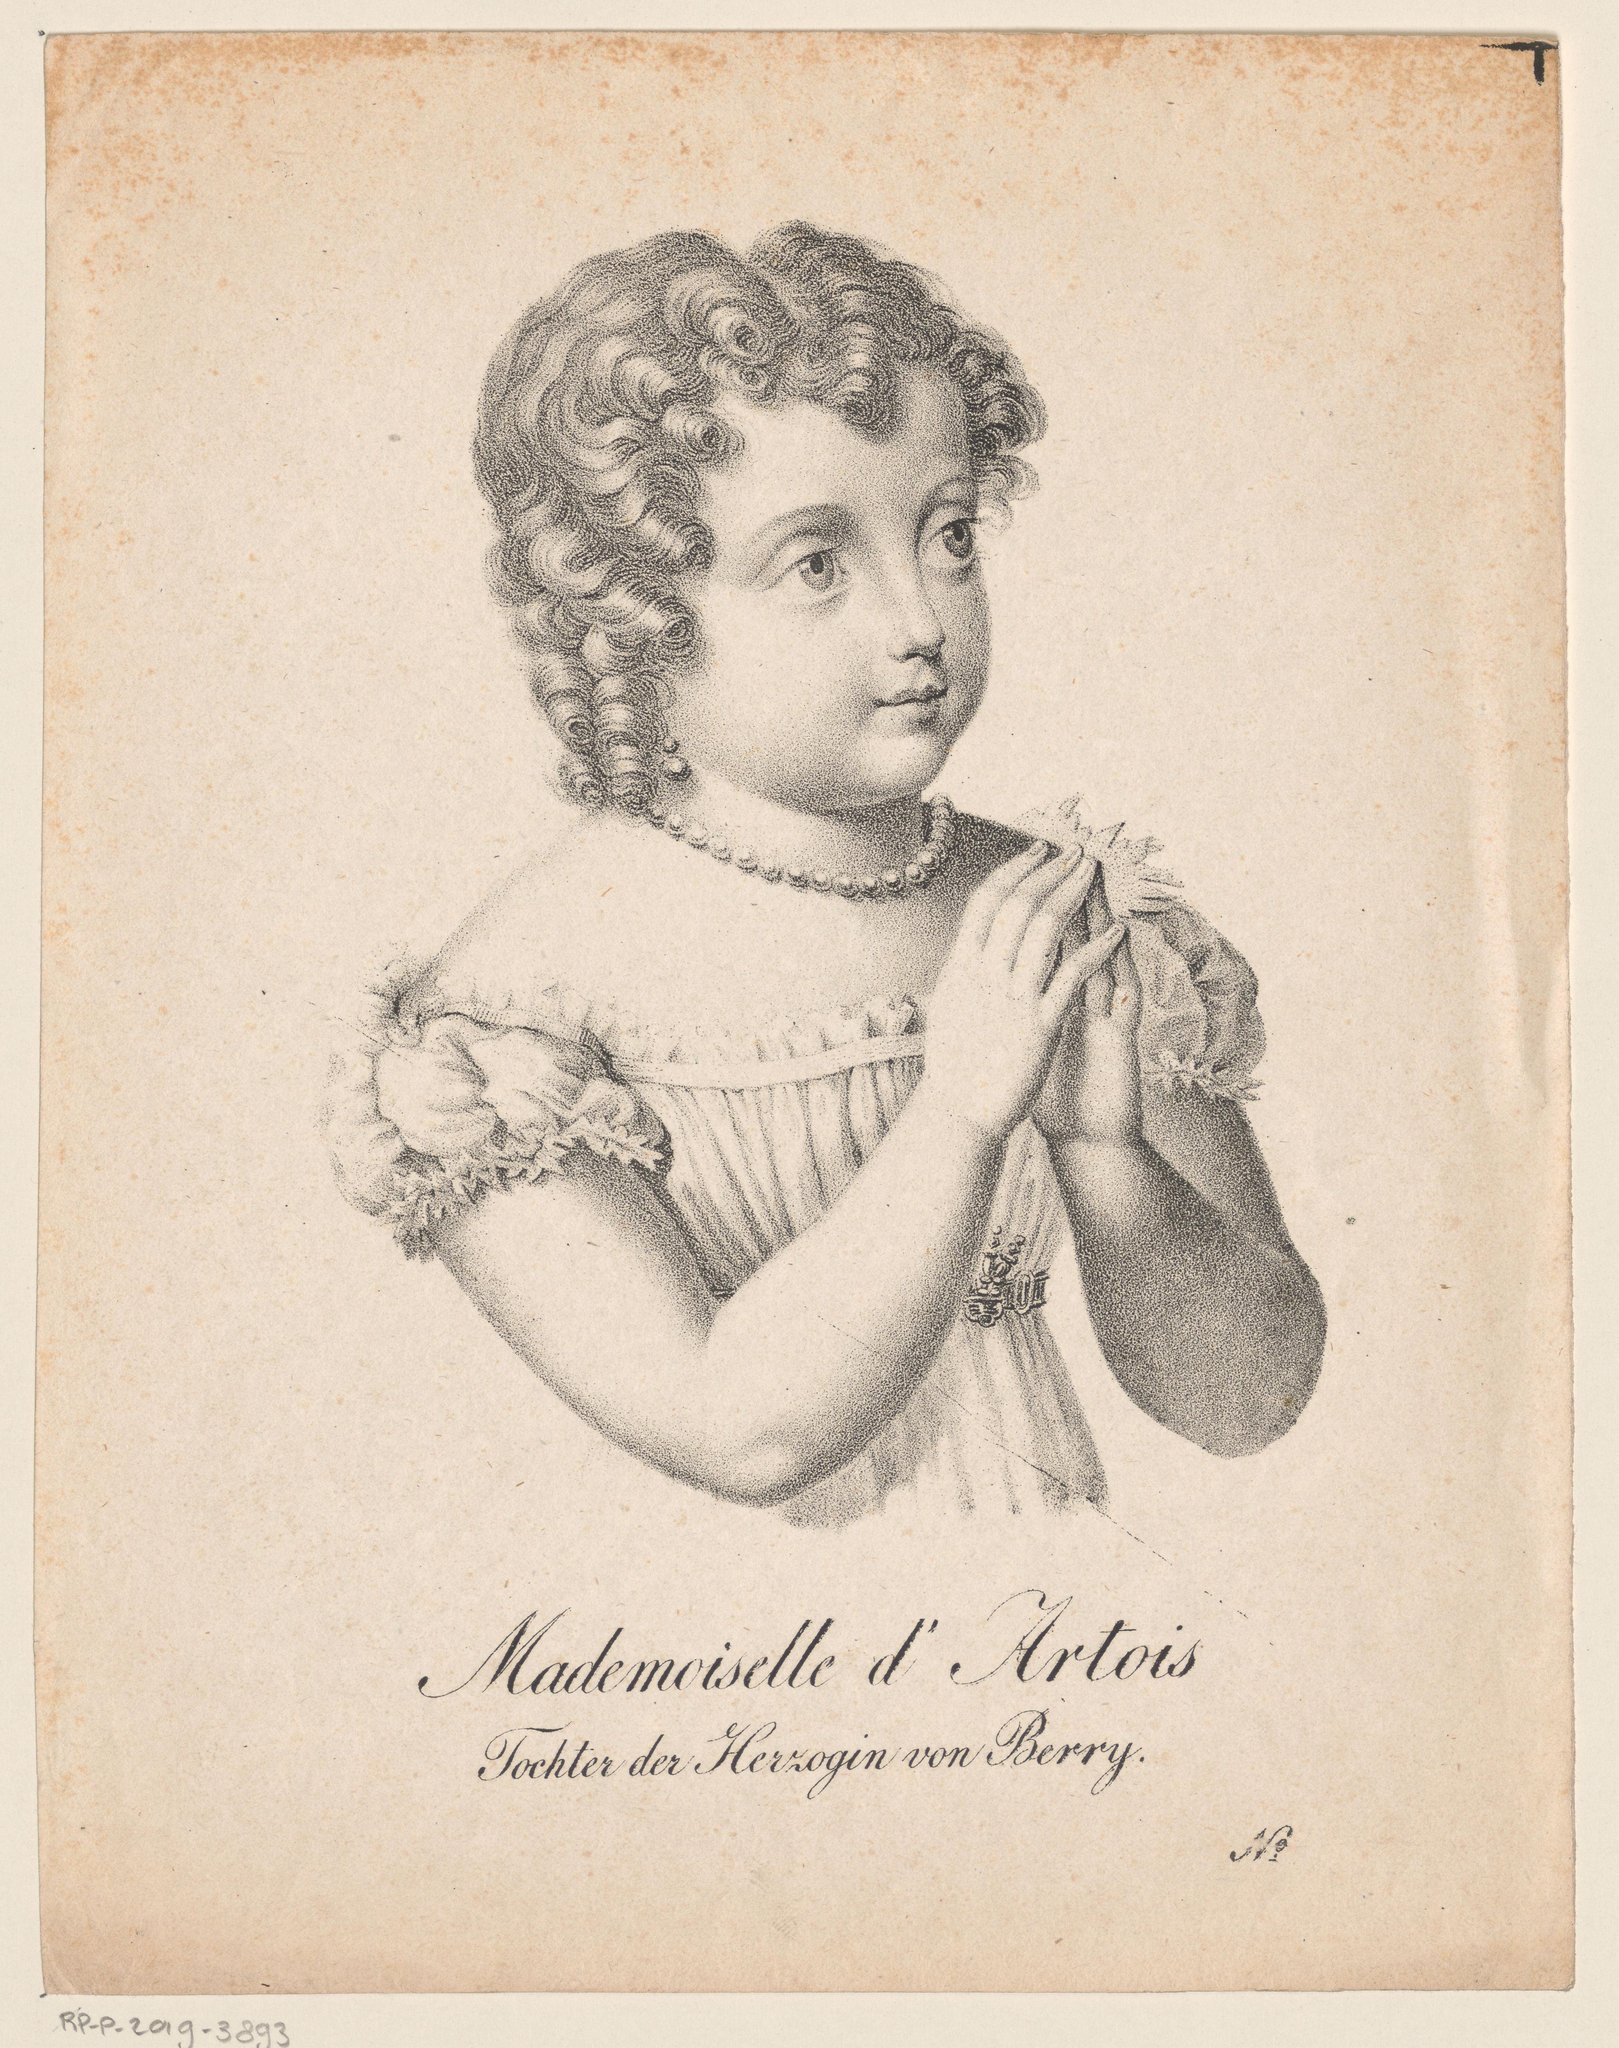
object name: print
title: Portret van Louise Marie Thérèse d'Artois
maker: Anonymous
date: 1820-1830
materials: paper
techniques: lithograph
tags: paris, louise d' artois, historical persons - bb - woman